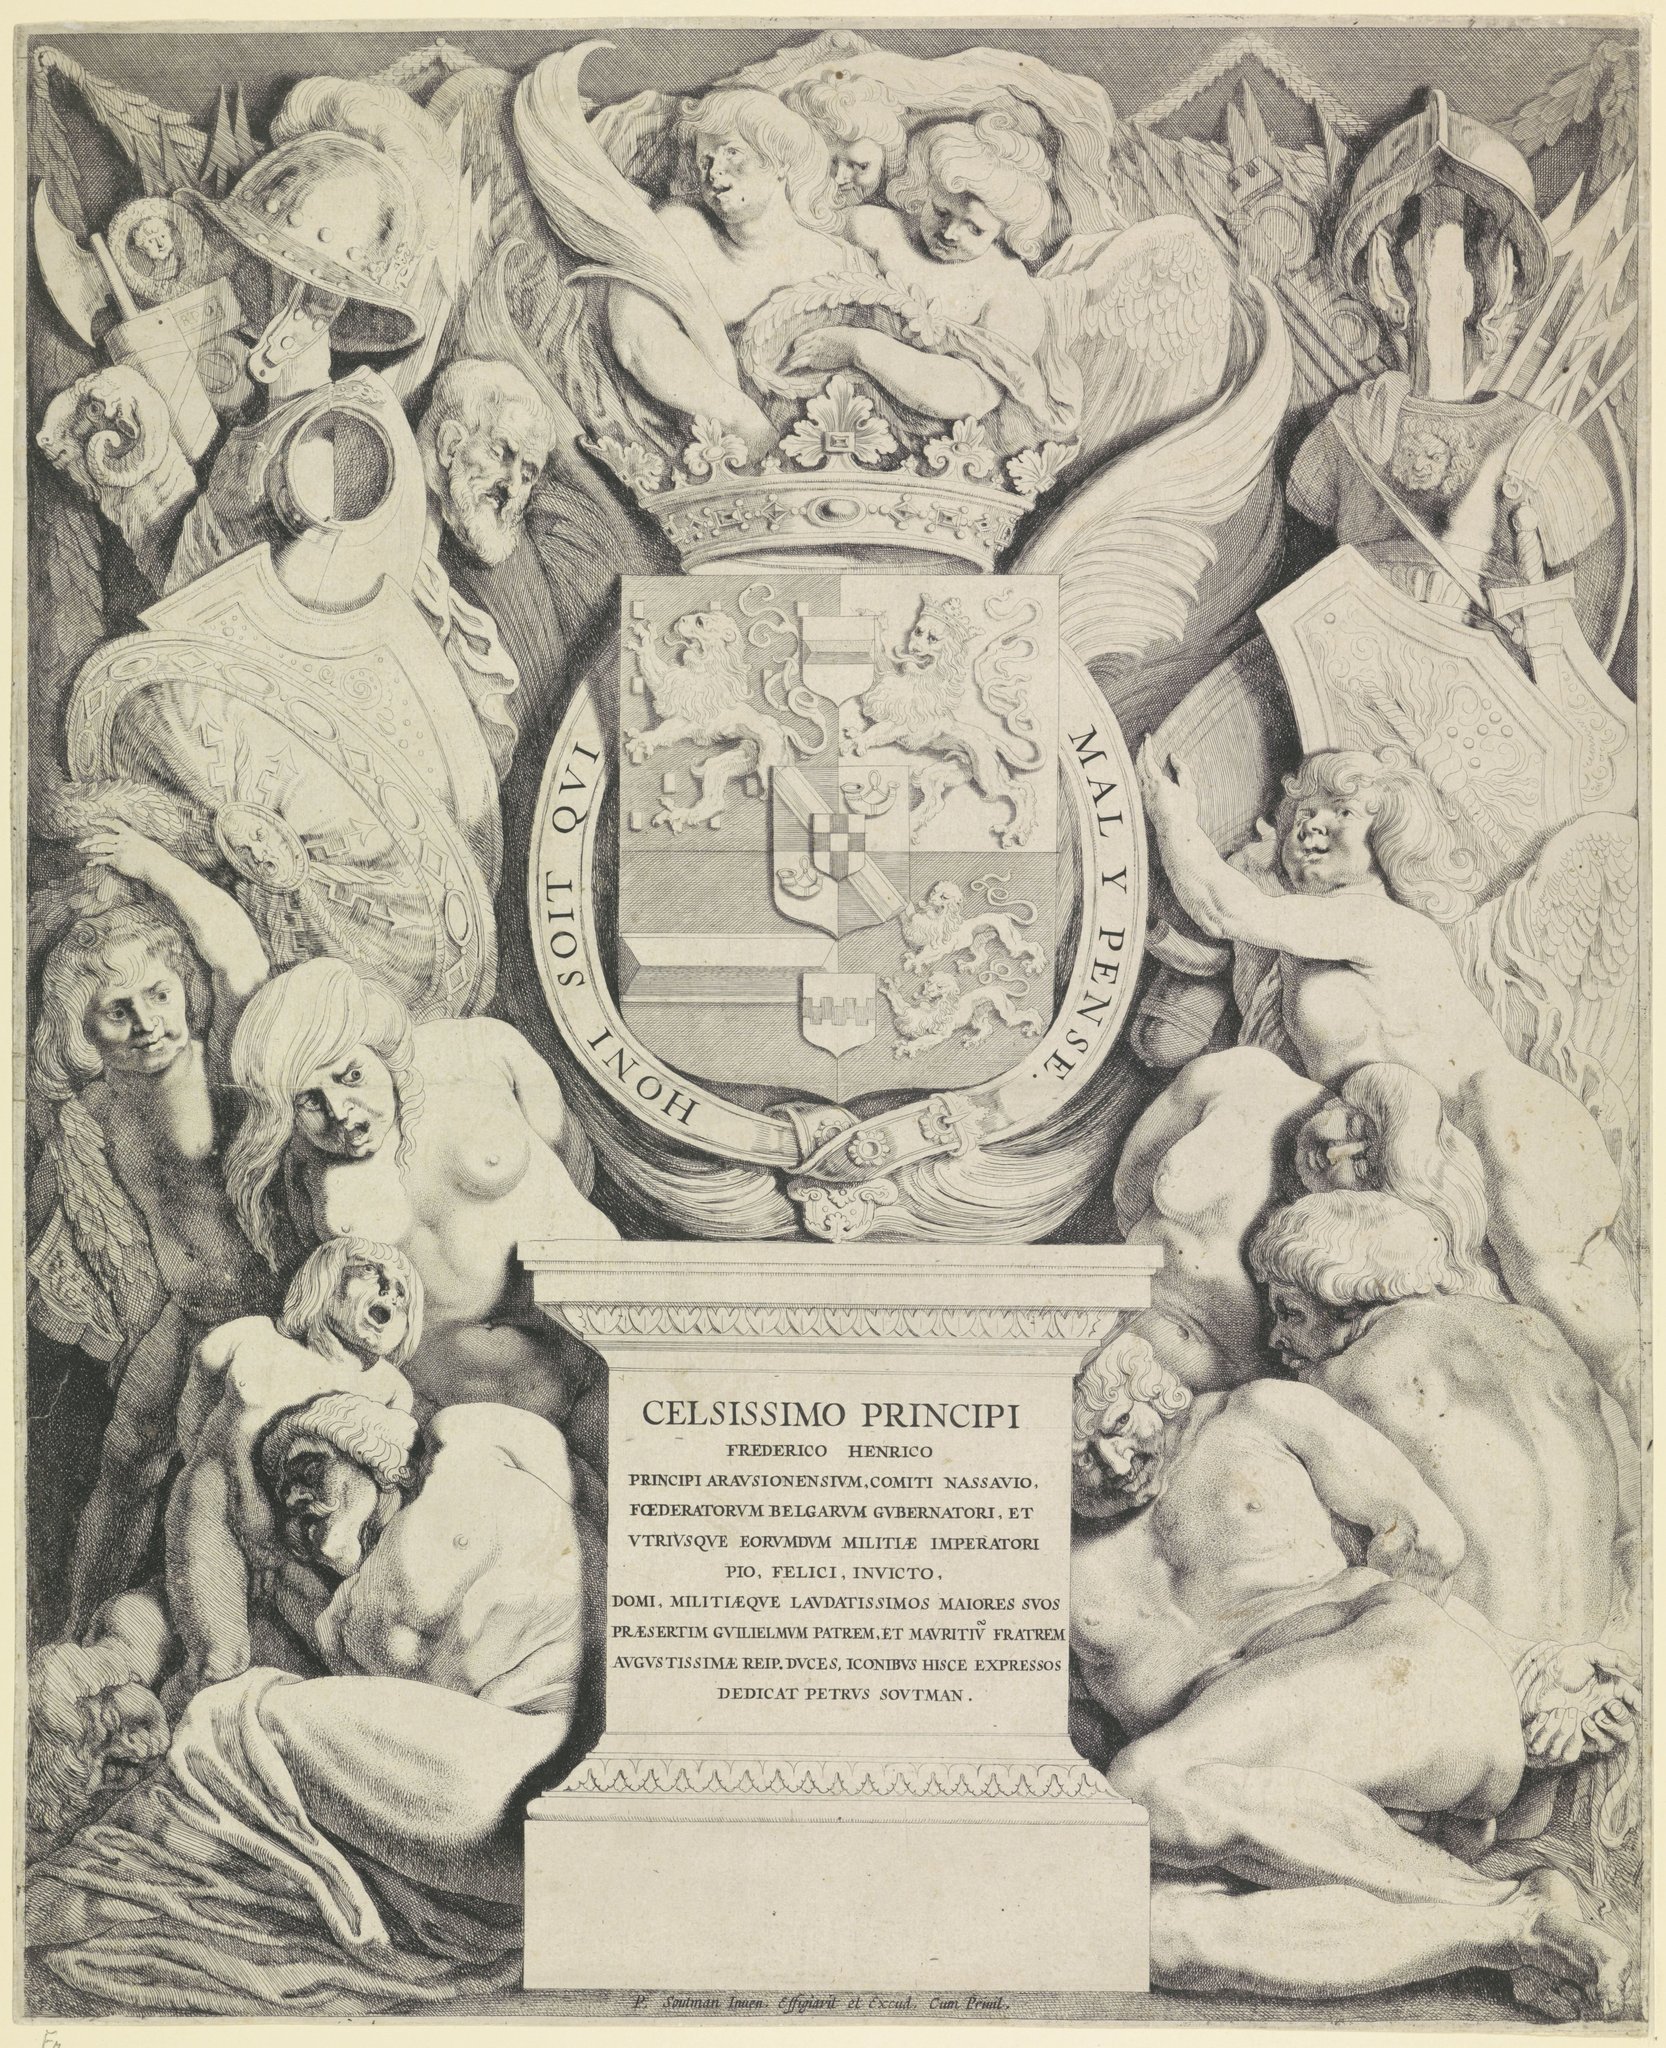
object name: print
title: Wapen van Frederik Hendrik, prins van Oranje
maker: pieter claesz. soutman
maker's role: draughtsman, print maker, publisher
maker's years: 1593-1657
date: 1627-1657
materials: paper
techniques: etching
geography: low countries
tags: delft, frederick henry (prince of orange), knighthood order (garter) - insignia of a knighthood order, e.g.: badge, chain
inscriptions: collector's mark: Lugt 963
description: Wapen van Frederik Hendrik met een kroon, gedecoreerd met de Kousenband en het devies van de Orde van de Kousenband. Daar omheen een aantal allegorische figuren en objecten. Op een voetstuk tien regels Latijnse tekst.